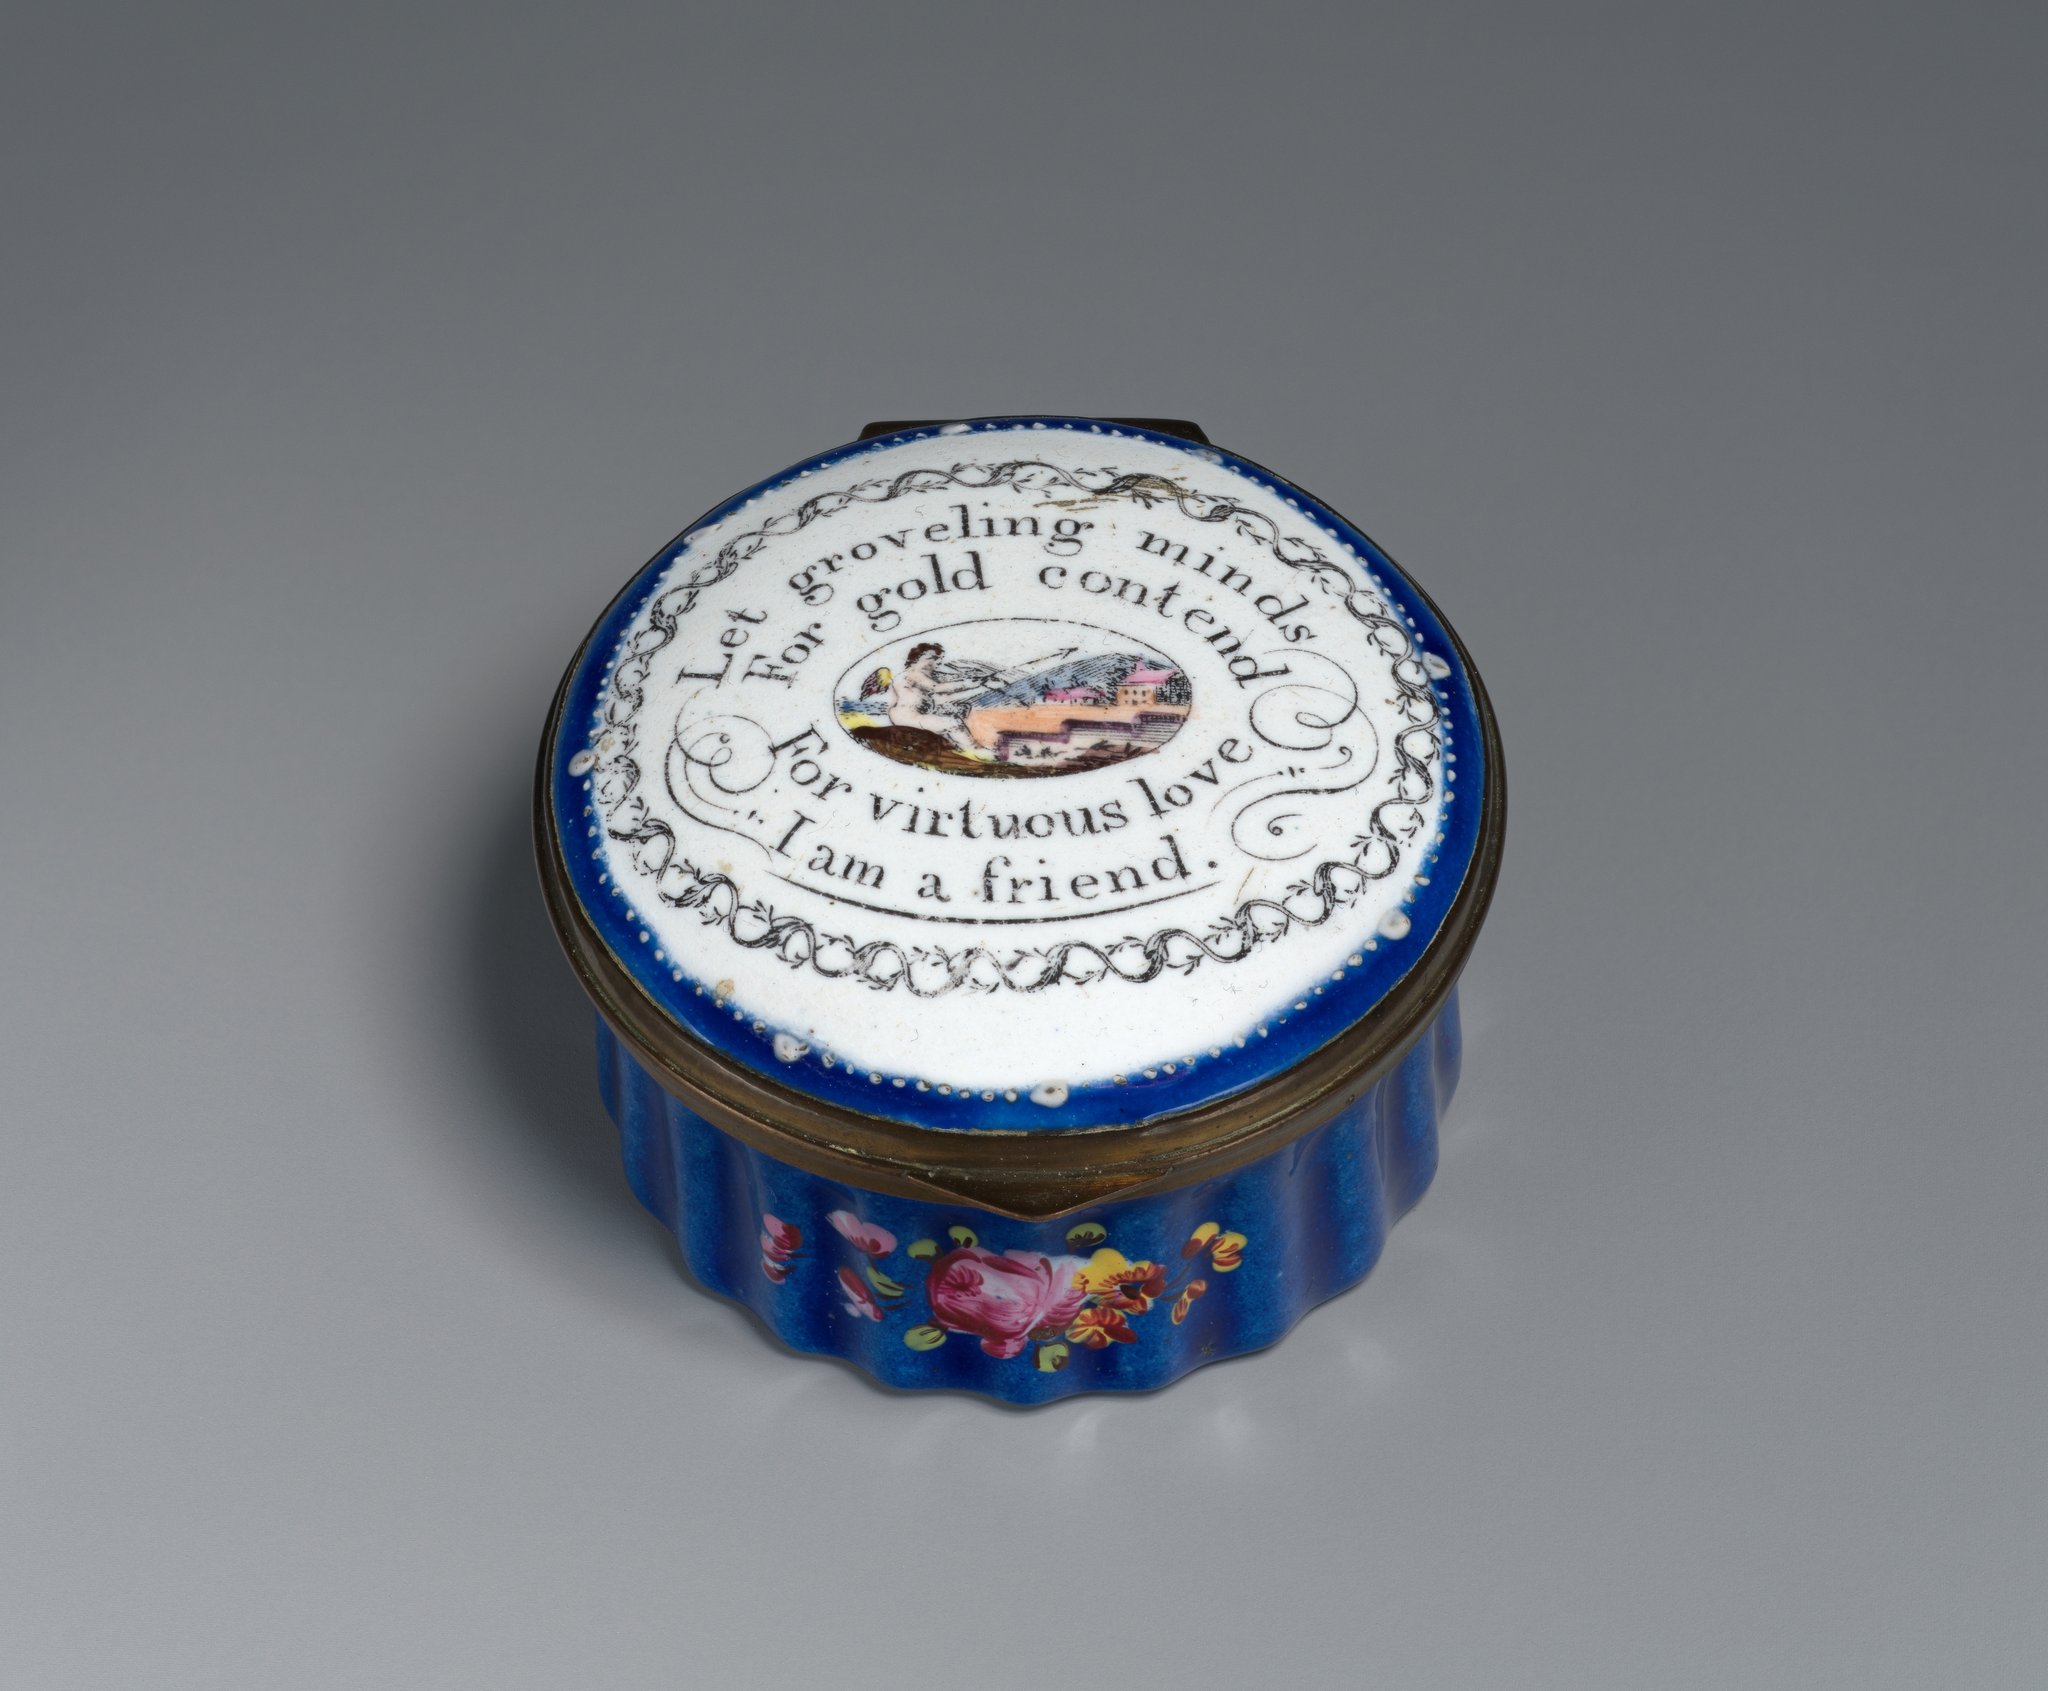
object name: patch box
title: Patch Box with Cupid, “Let groveling minds / For gold contend / For virtuous love / I am a Friend.”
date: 1770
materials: copper, enamel, glass